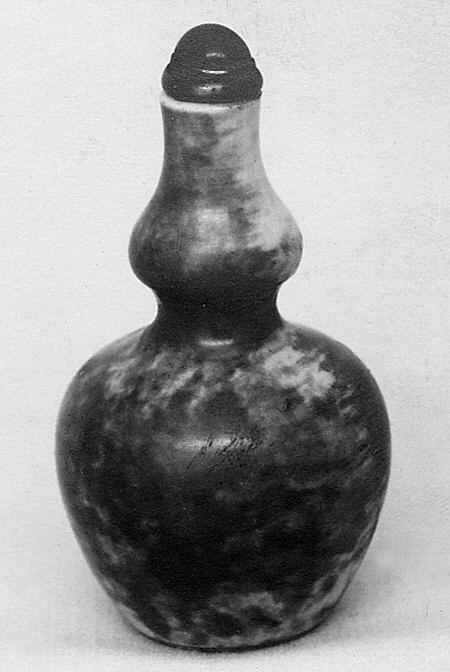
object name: snuff bottle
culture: chinese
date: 1723-1735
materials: porcelain